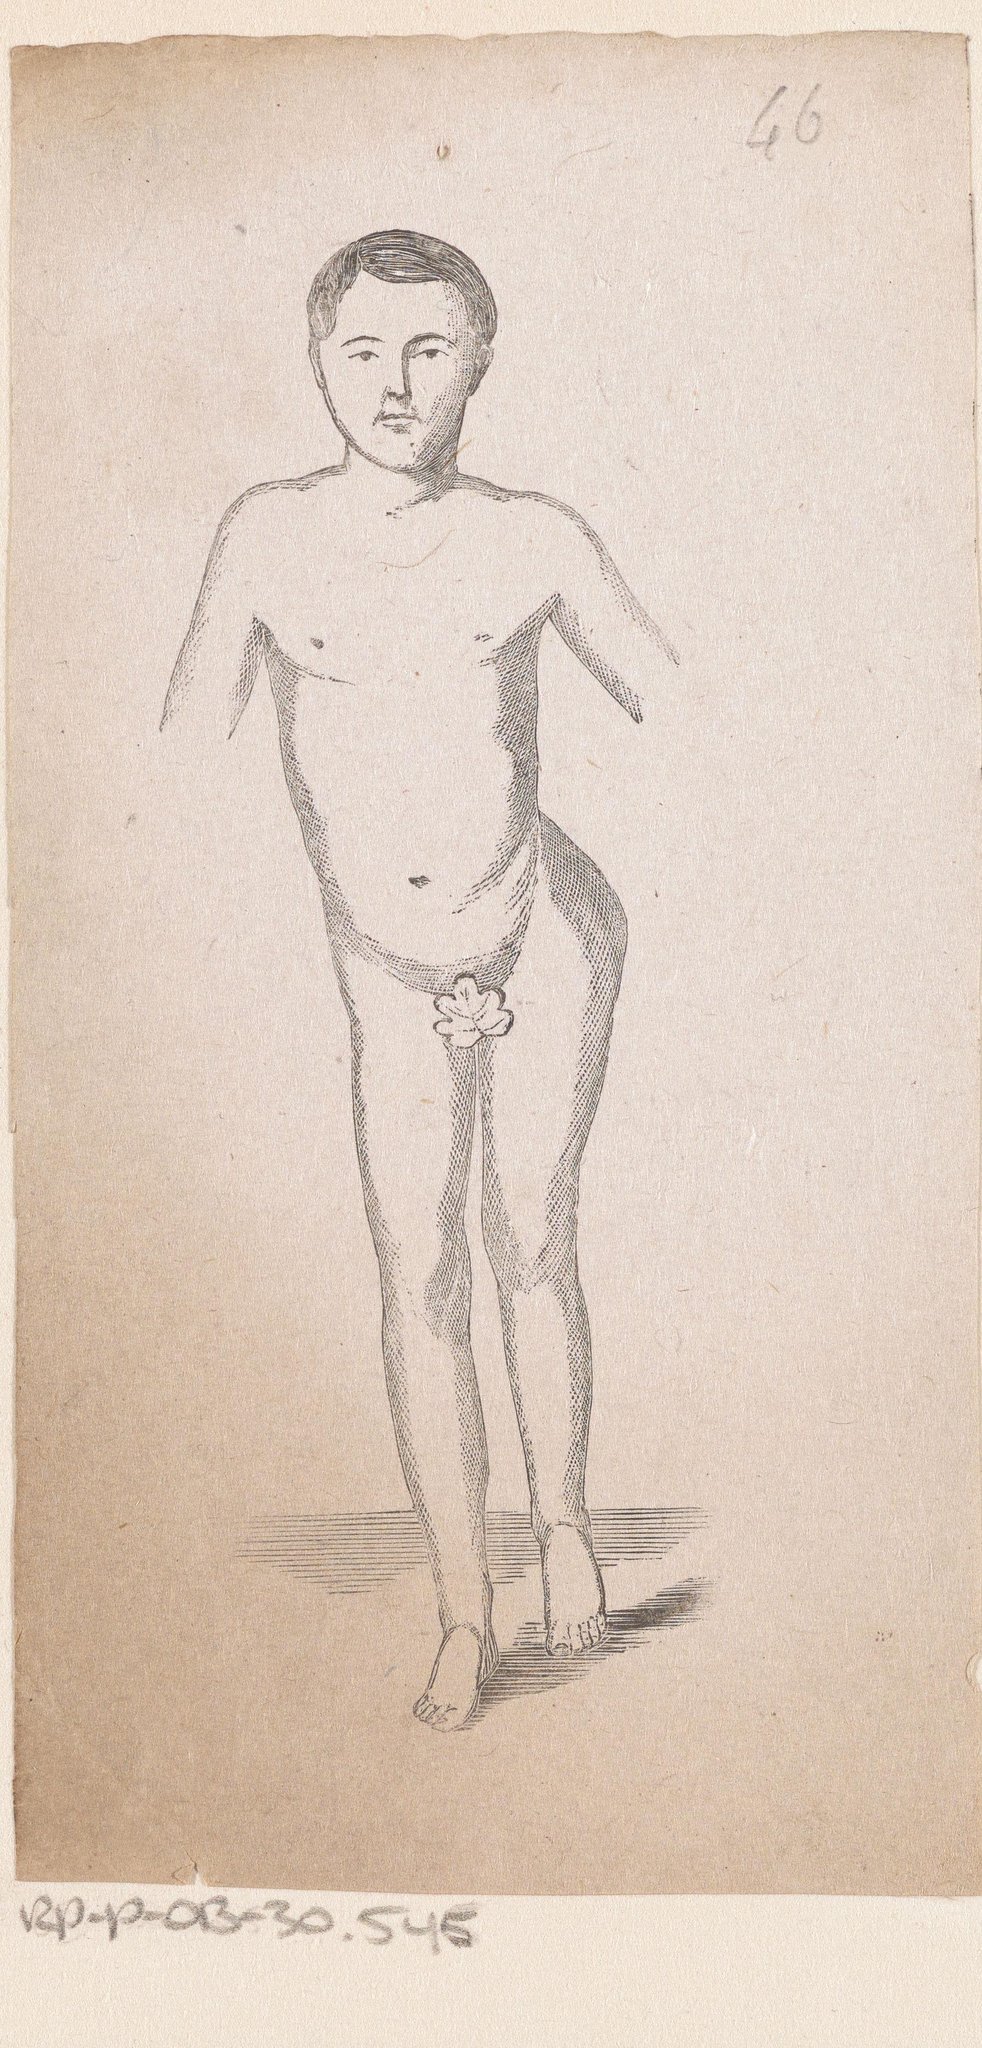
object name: print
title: Man met een afwijking in het bekken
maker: isaac weissenbruch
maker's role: print maker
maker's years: 1826-1912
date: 1836-1912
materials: paper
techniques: engraving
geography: netherlands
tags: pelvis, disabilities, deformations and monstrosities; diseases